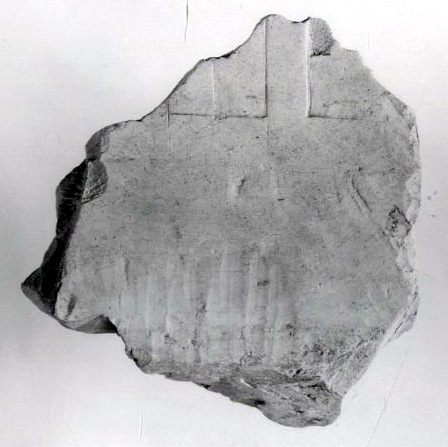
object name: relief fragment, tomb of meketre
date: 1981-1975 BCE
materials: limestone, paint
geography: egypt